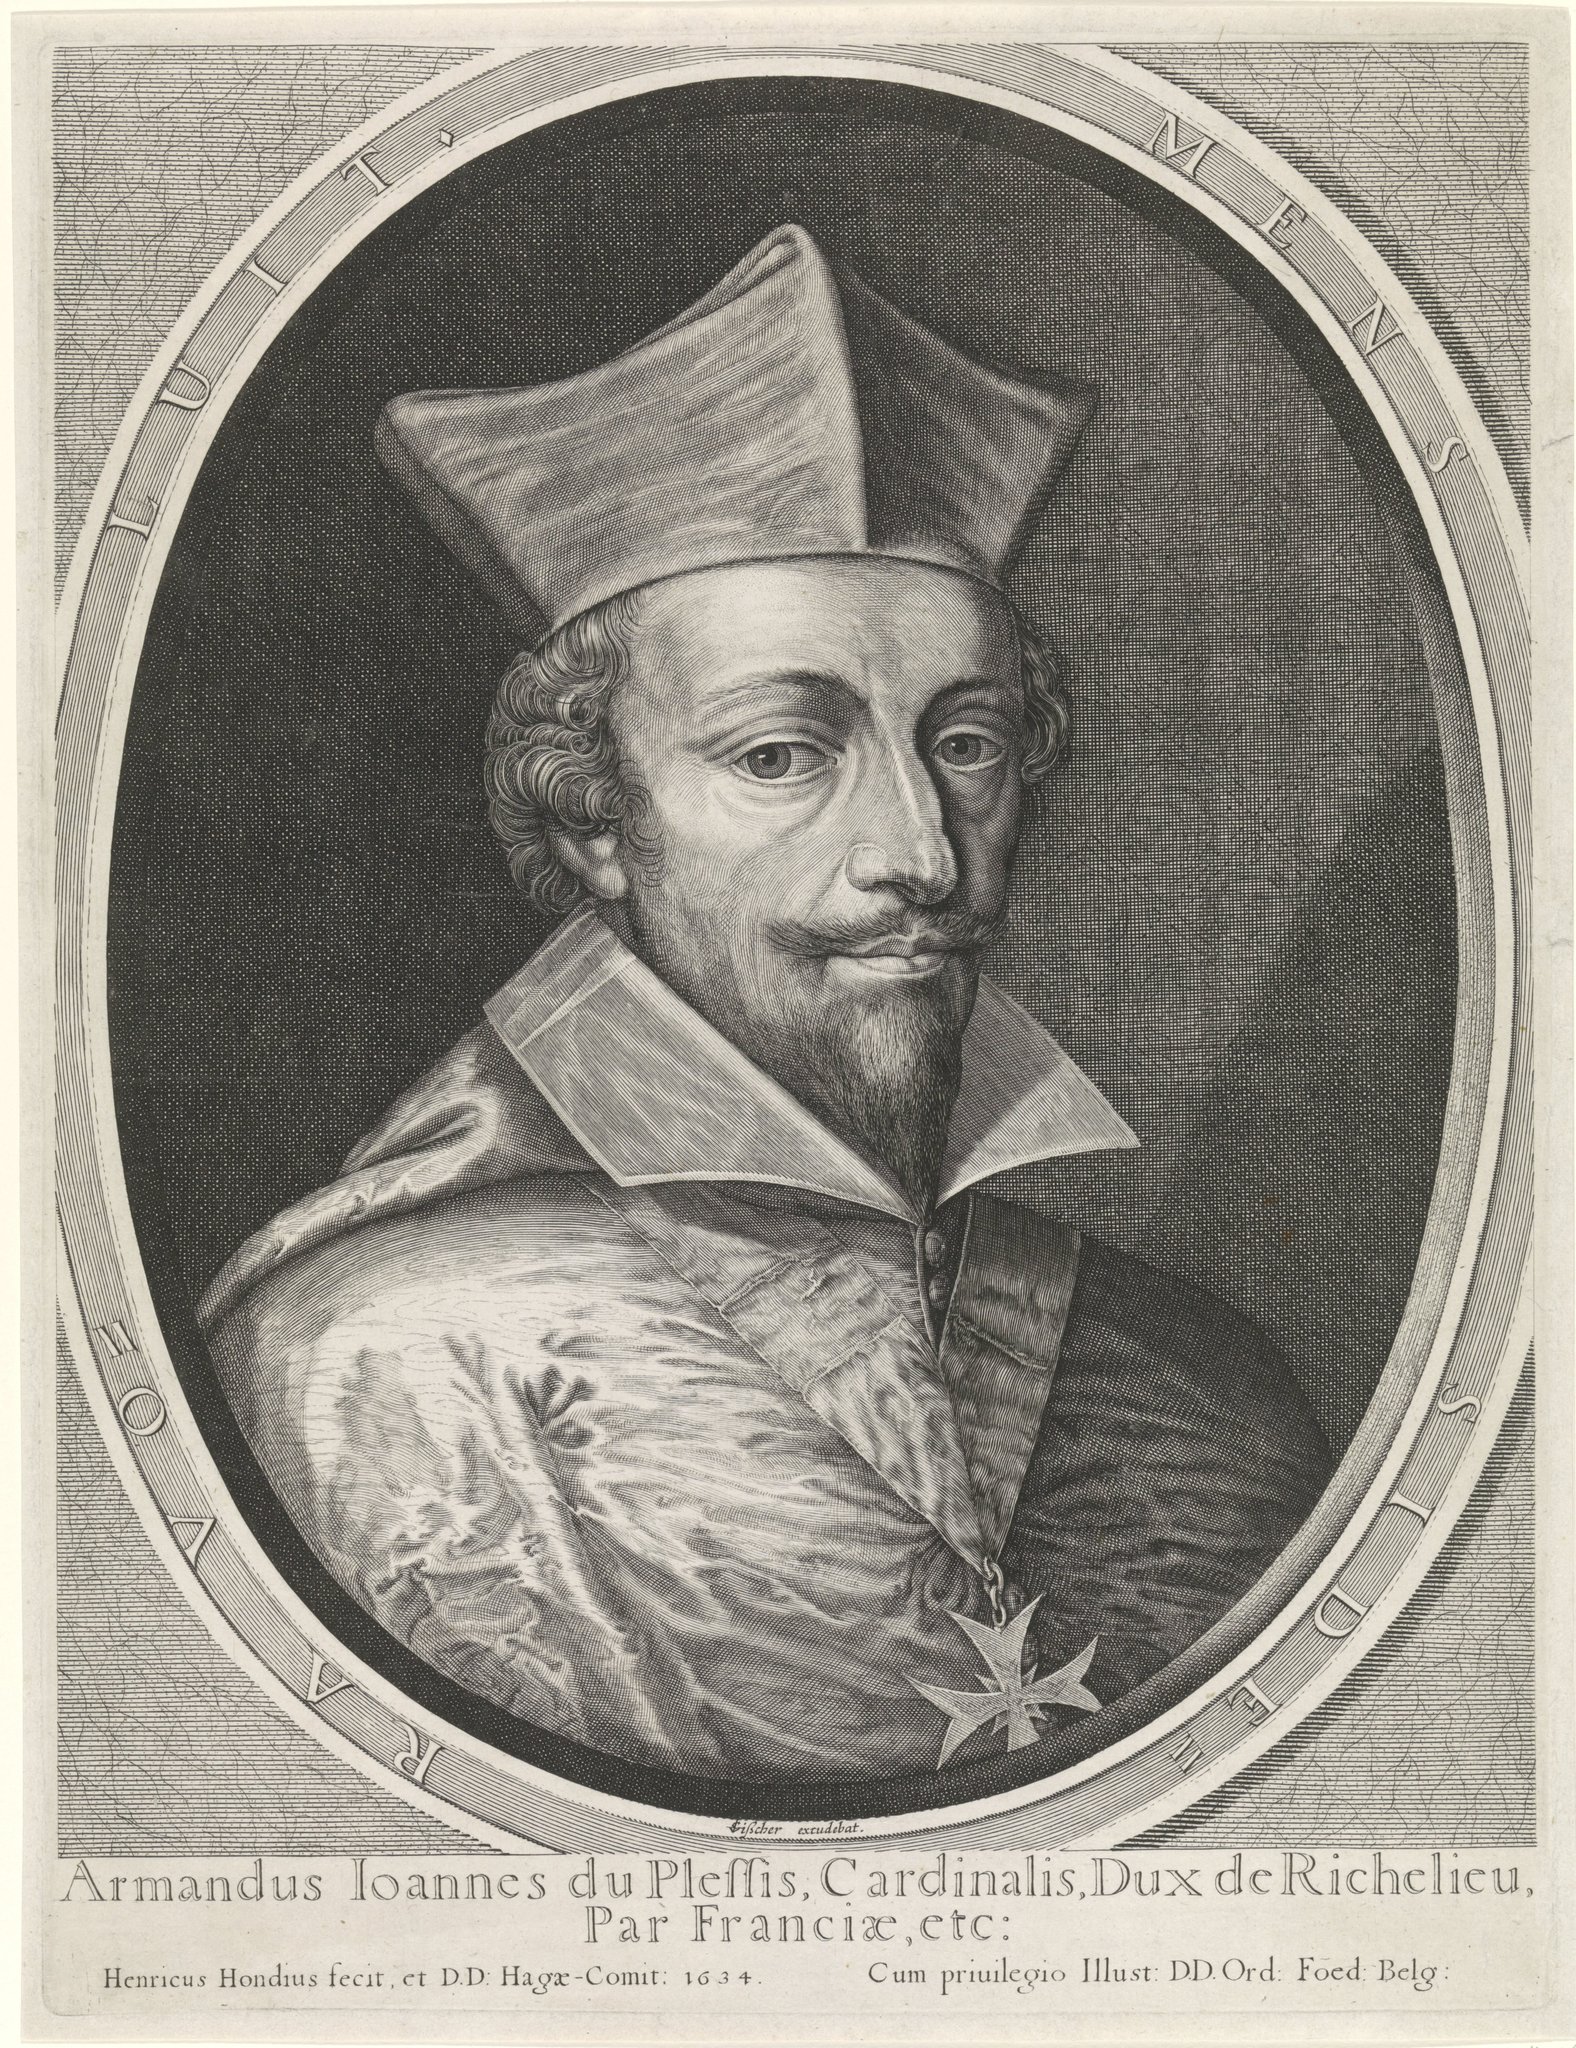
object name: print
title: Portret van Armand-Jean du Plessis, hertog van Richelieu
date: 1634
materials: paper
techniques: engraving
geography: amsterdam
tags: paris, armand-jean du plessis hertog van richelieu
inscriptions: collector's mark: Lugt 2228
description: Bustenaar rechts van Portret van Armand-Jean du Plessis, hertog van Richelieu in een ovale omlijsting met randscharift in het Latijn. Onder het portret twee regels in het Latijn.